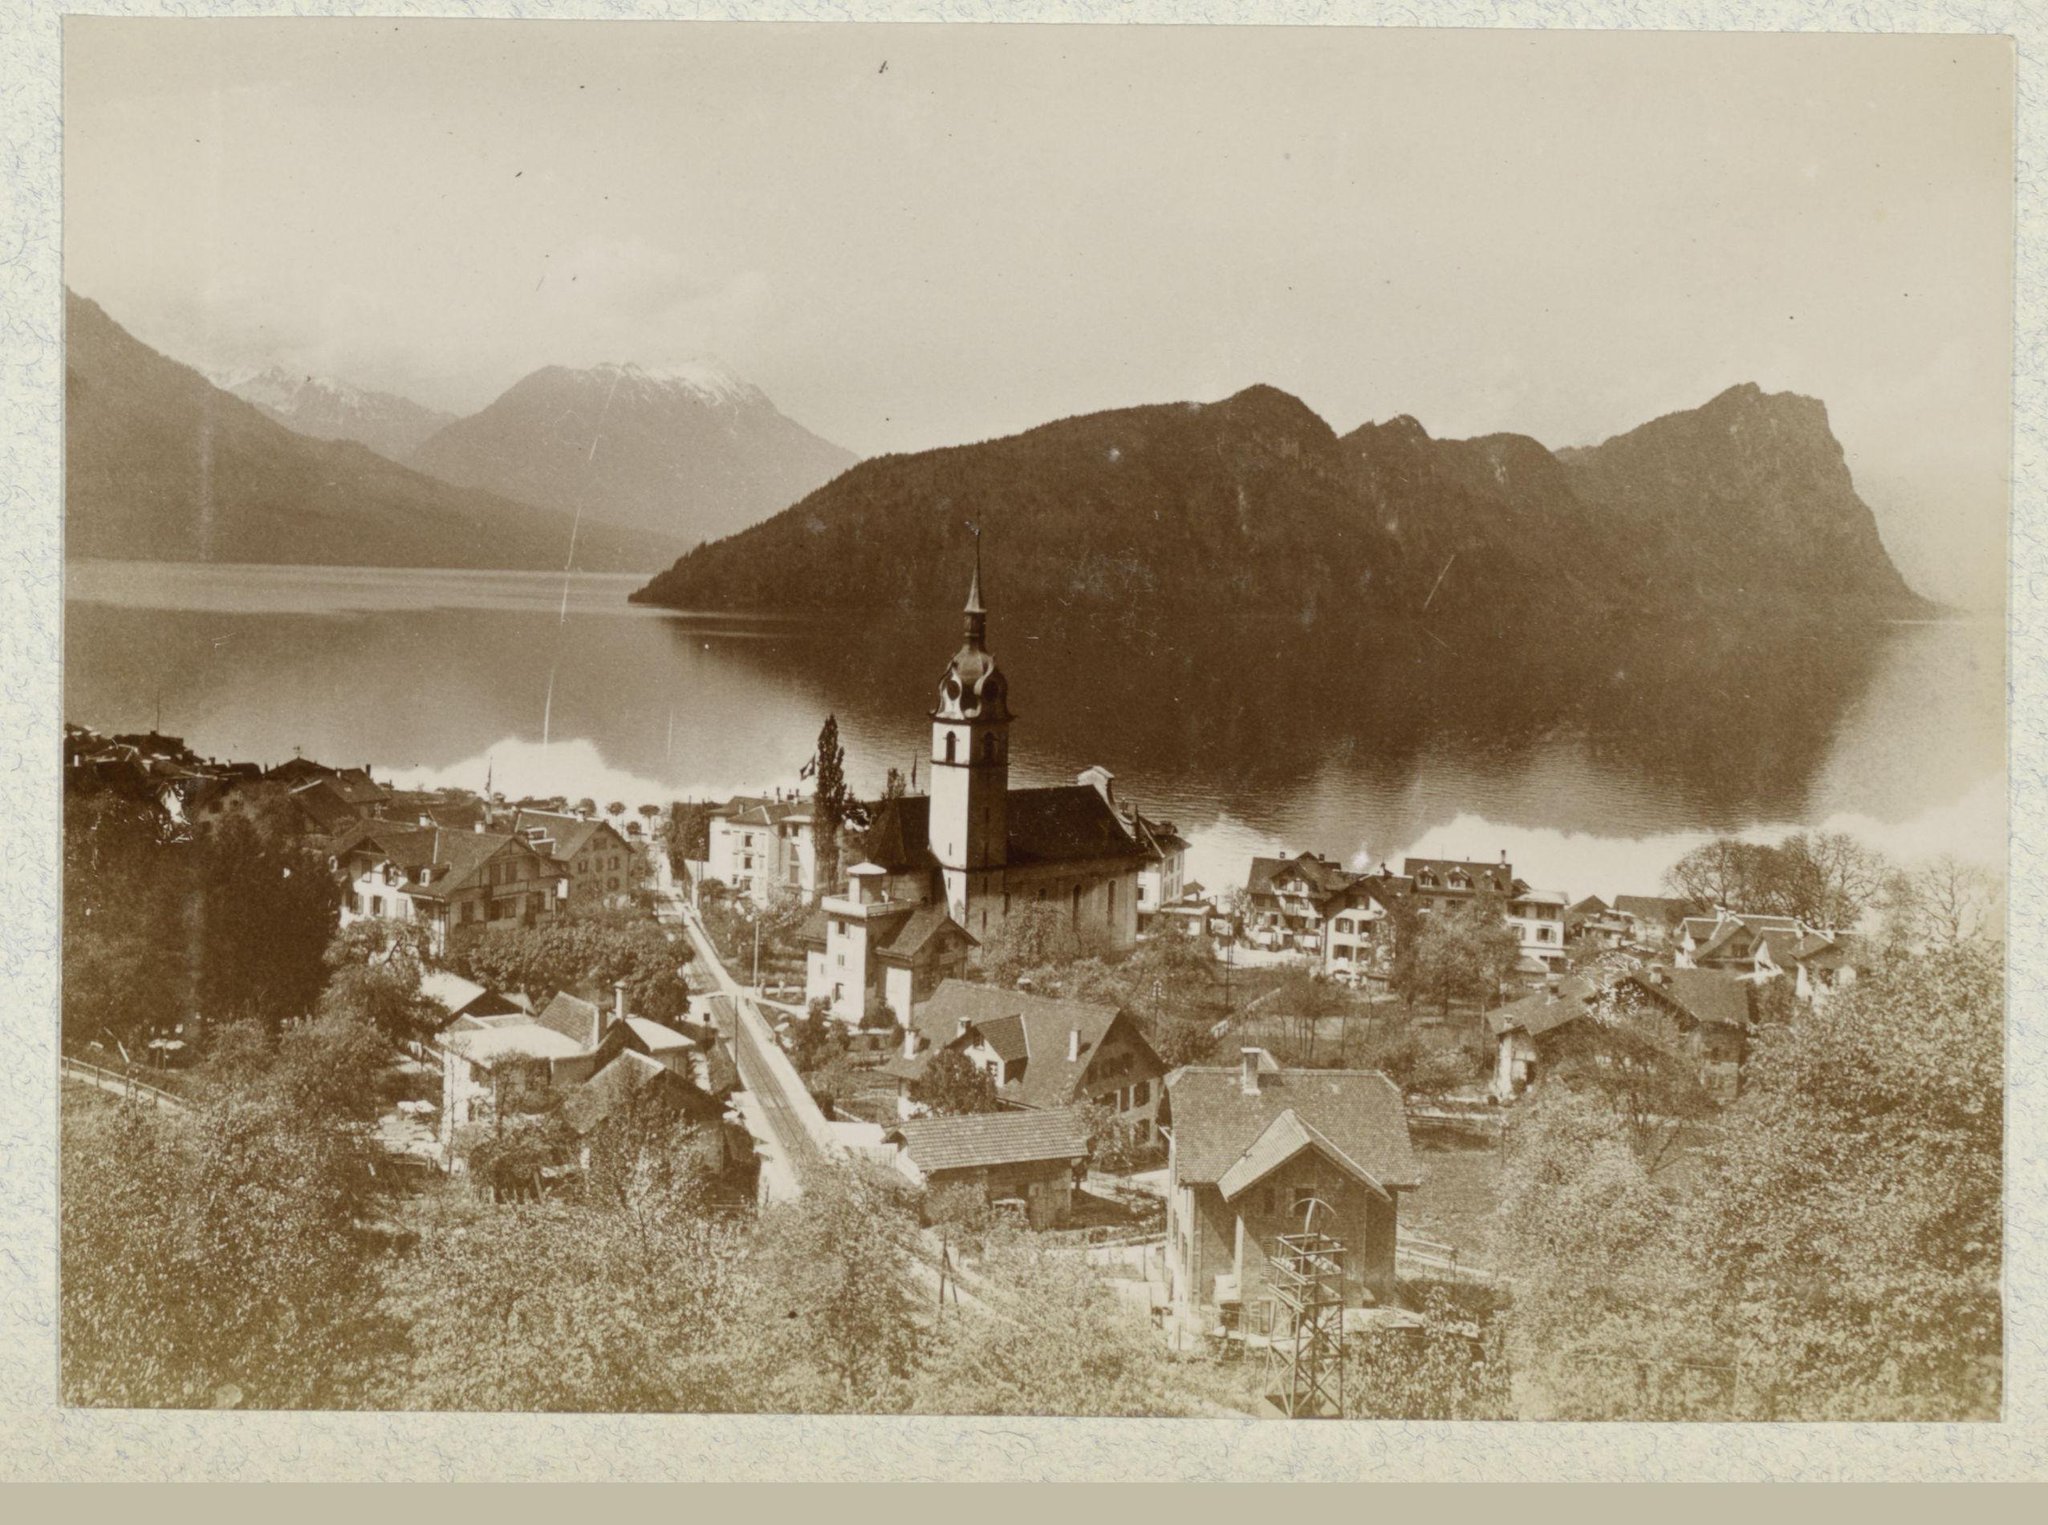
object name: photograph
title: Vakantie in Zwitserland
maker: andries augustus boom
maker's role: amateurfotograaf, handelaar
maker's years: 1878-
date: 1805-1899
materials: photographic support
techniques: photography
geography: switzerland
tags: amsterdam, andries augustus boom, switzerland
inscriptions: date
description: Vakantie in Zwitserland bij de Vierwoudstrekenmeer (Vierwaldstättersee). Onderdeel van het fotoalbum van de familie Boom-Gonggrijp in Suriname en Curaçao.